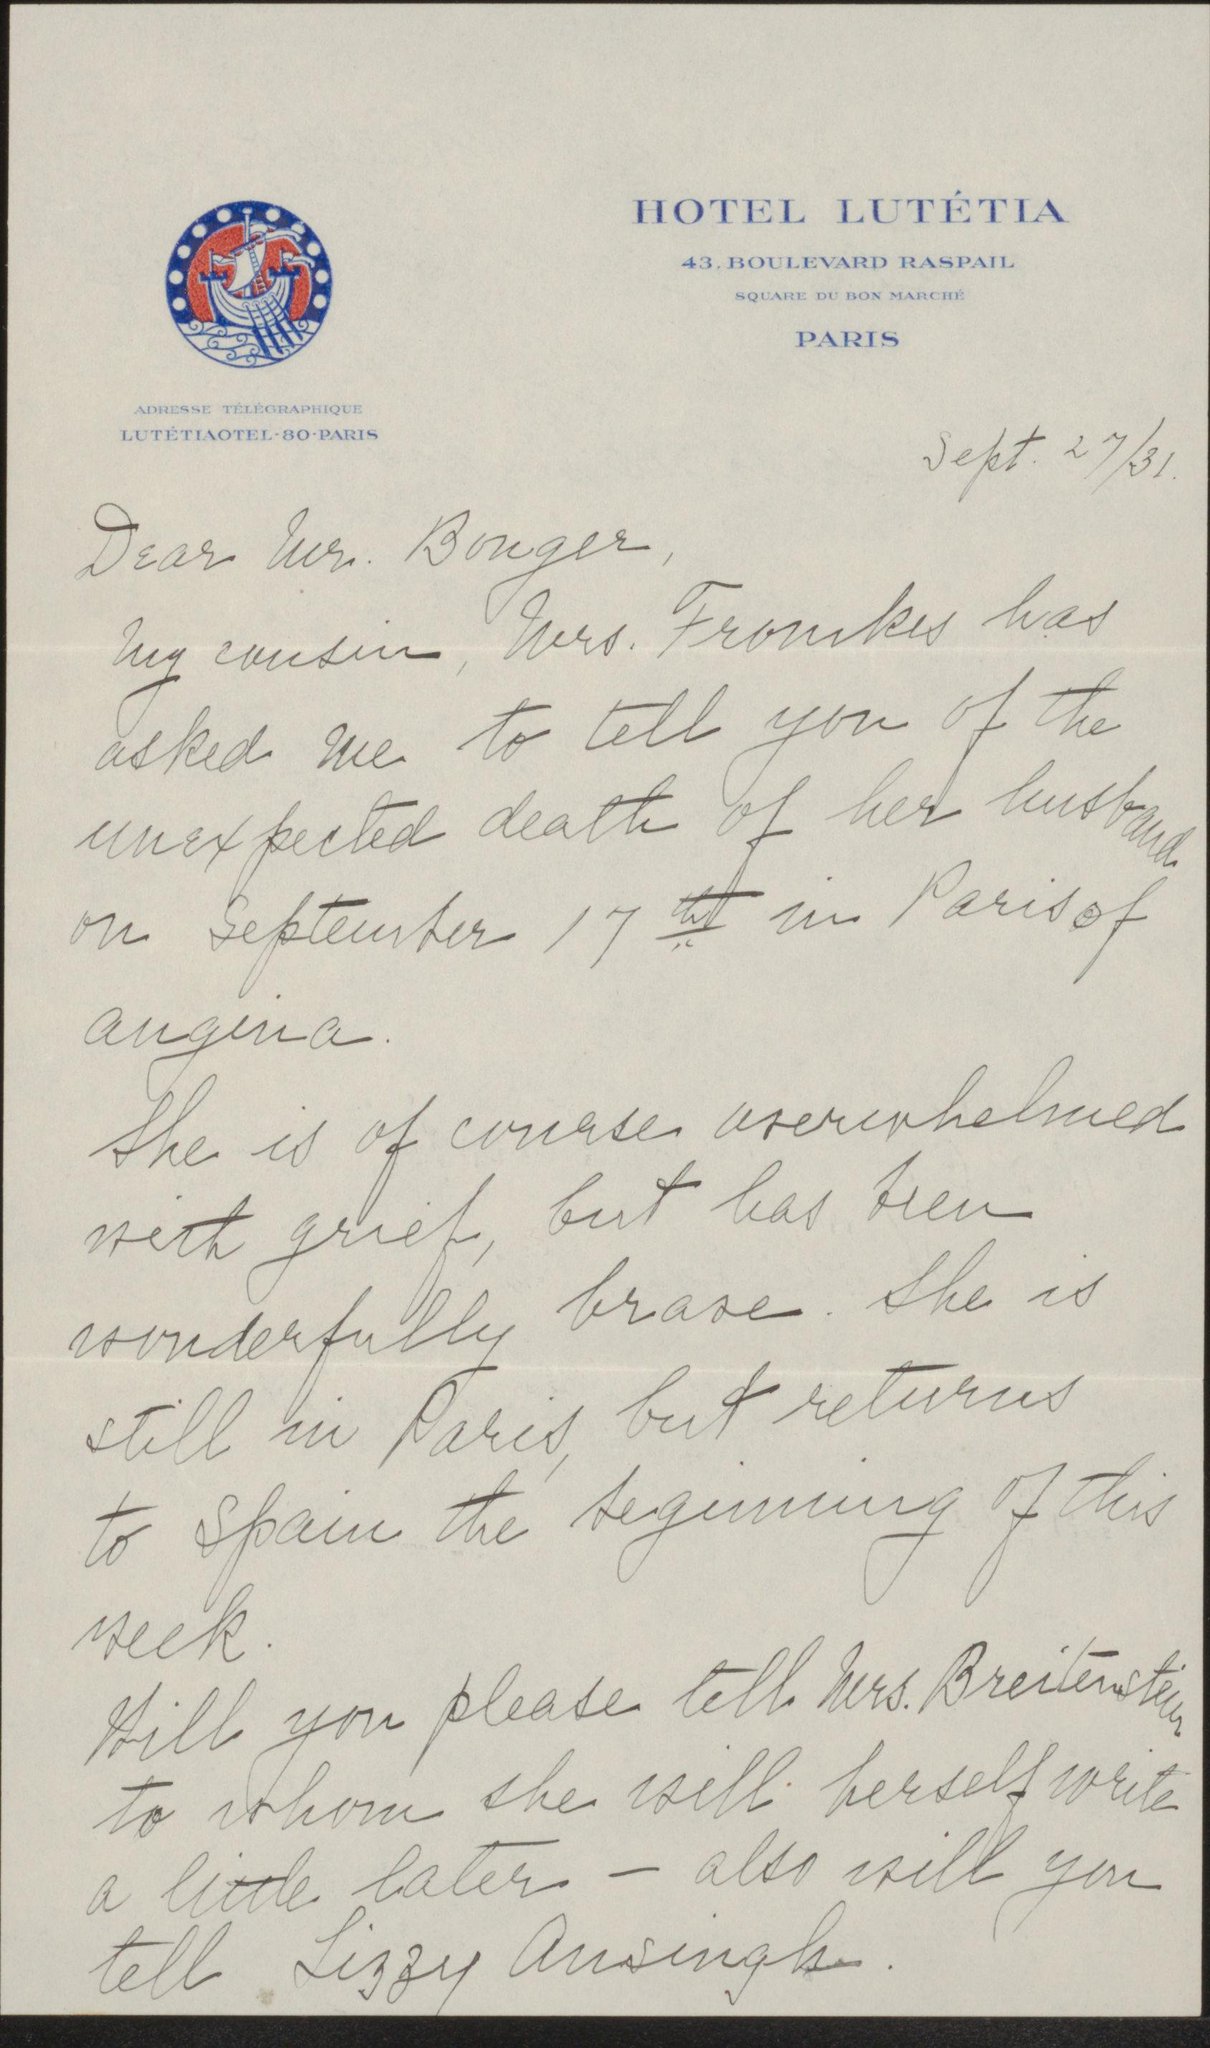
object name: letter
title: Brief aan Andries Bonger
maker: sadie van praag marks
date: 1931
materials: ink, paper, pencil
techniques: pen, printing, writing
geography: paris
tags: paris, maurice fromkes, eva halle fromkes, utrecht, painter, print maker, draughtsman, lizzy ansingh, andries bonger, spain